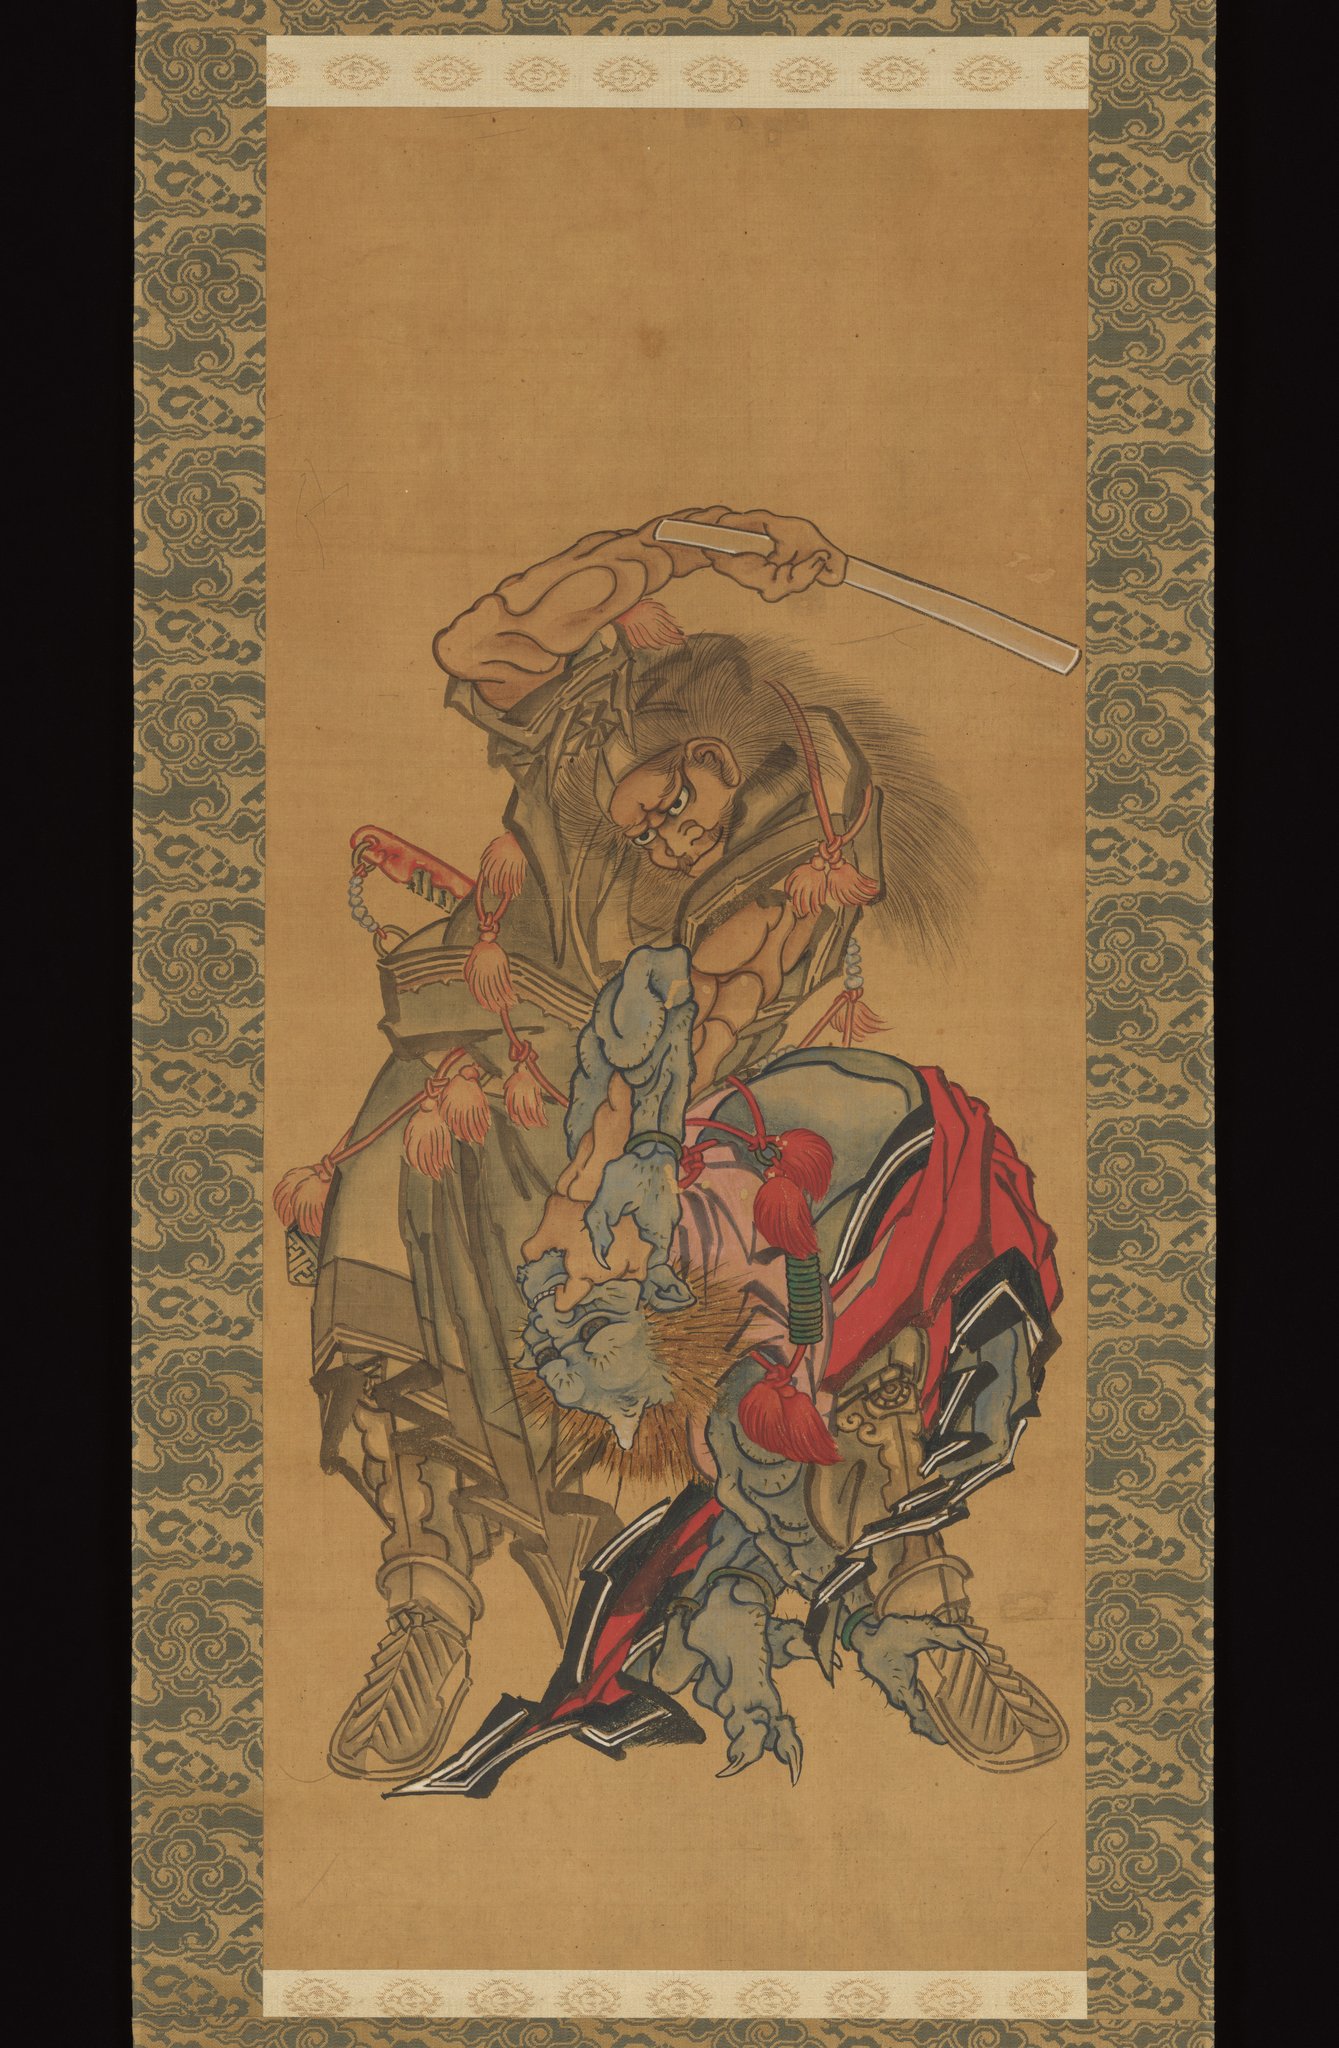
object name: hanging scroll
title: Shōki, the Demon Queller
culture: japanese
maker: katsushika hokusai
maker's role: artist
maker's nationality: japanese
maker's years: 1760-1849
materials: ink, silk